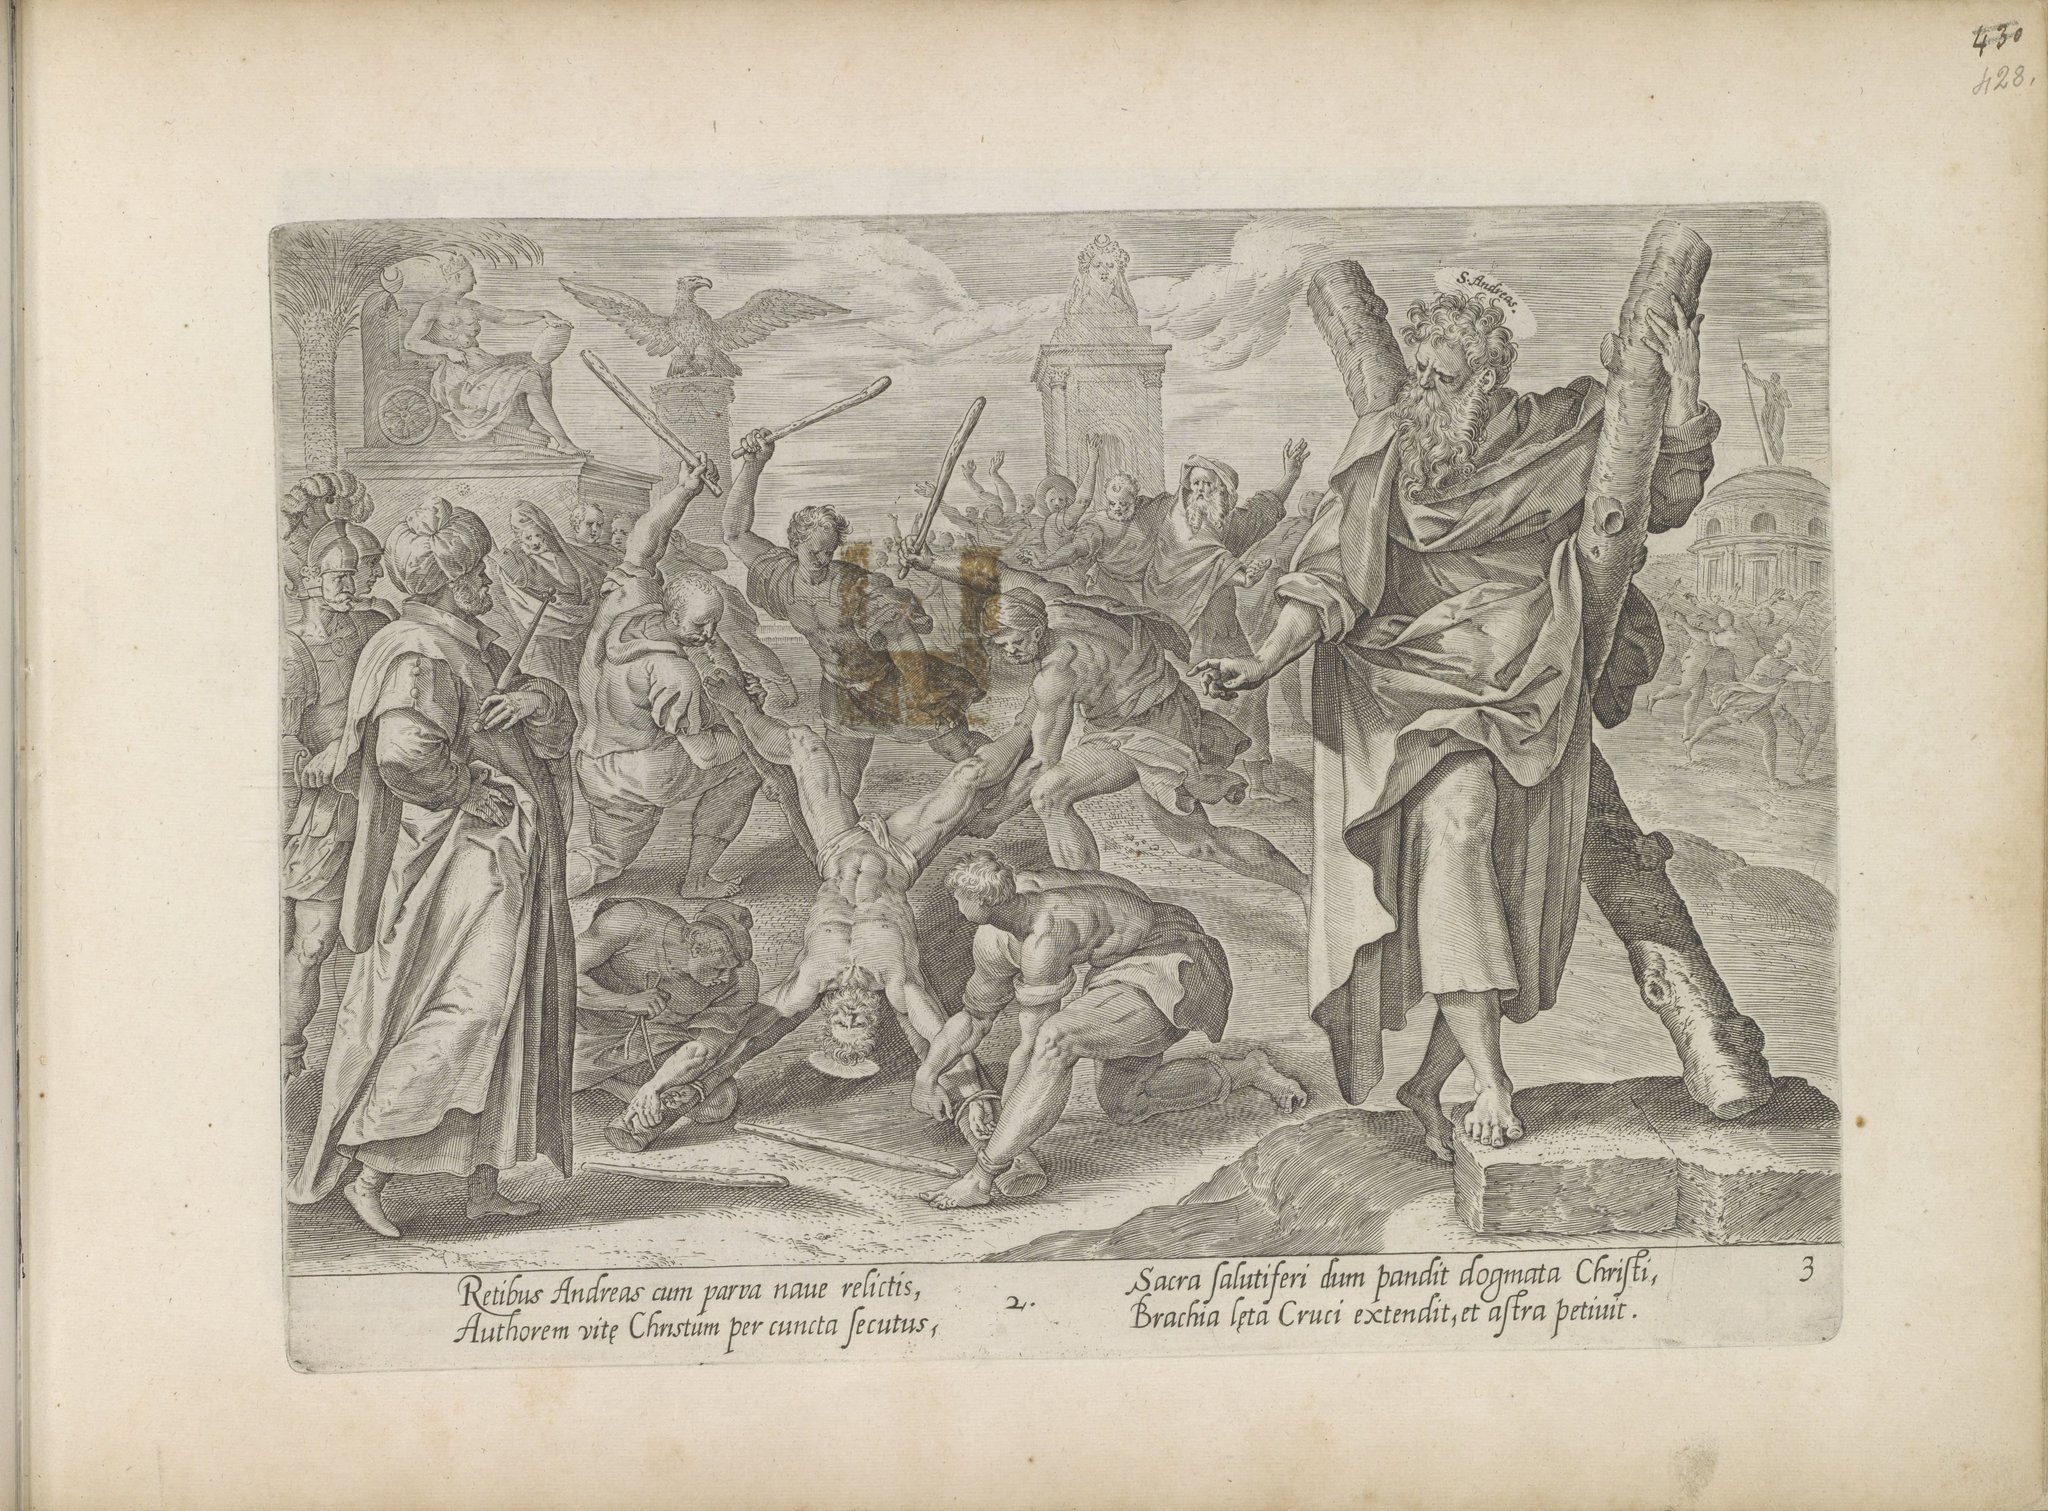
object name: album leaf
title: Martelaarschap van Andreas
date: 1576-1580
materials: paper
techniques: engraving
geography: amsterdam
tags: crucifixion of andrew: he is undressed and tied to the cross, the apostle andrew; possible attributes: book, x-shaped cross, fish, fishing-net, rope, scroll - martyrdom, suffering, misfortune, death of male saint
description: Andreas wordt gekruisigd op een X-vormig kruis. Rechts naast het tafereel van zijn marteldood staat hij nogmaals afgebeeld, met zijn Andreaskruis. Onder de voorstelling een verklarende tekst in het Latijn. Deze prent maakt deel uit van een album.